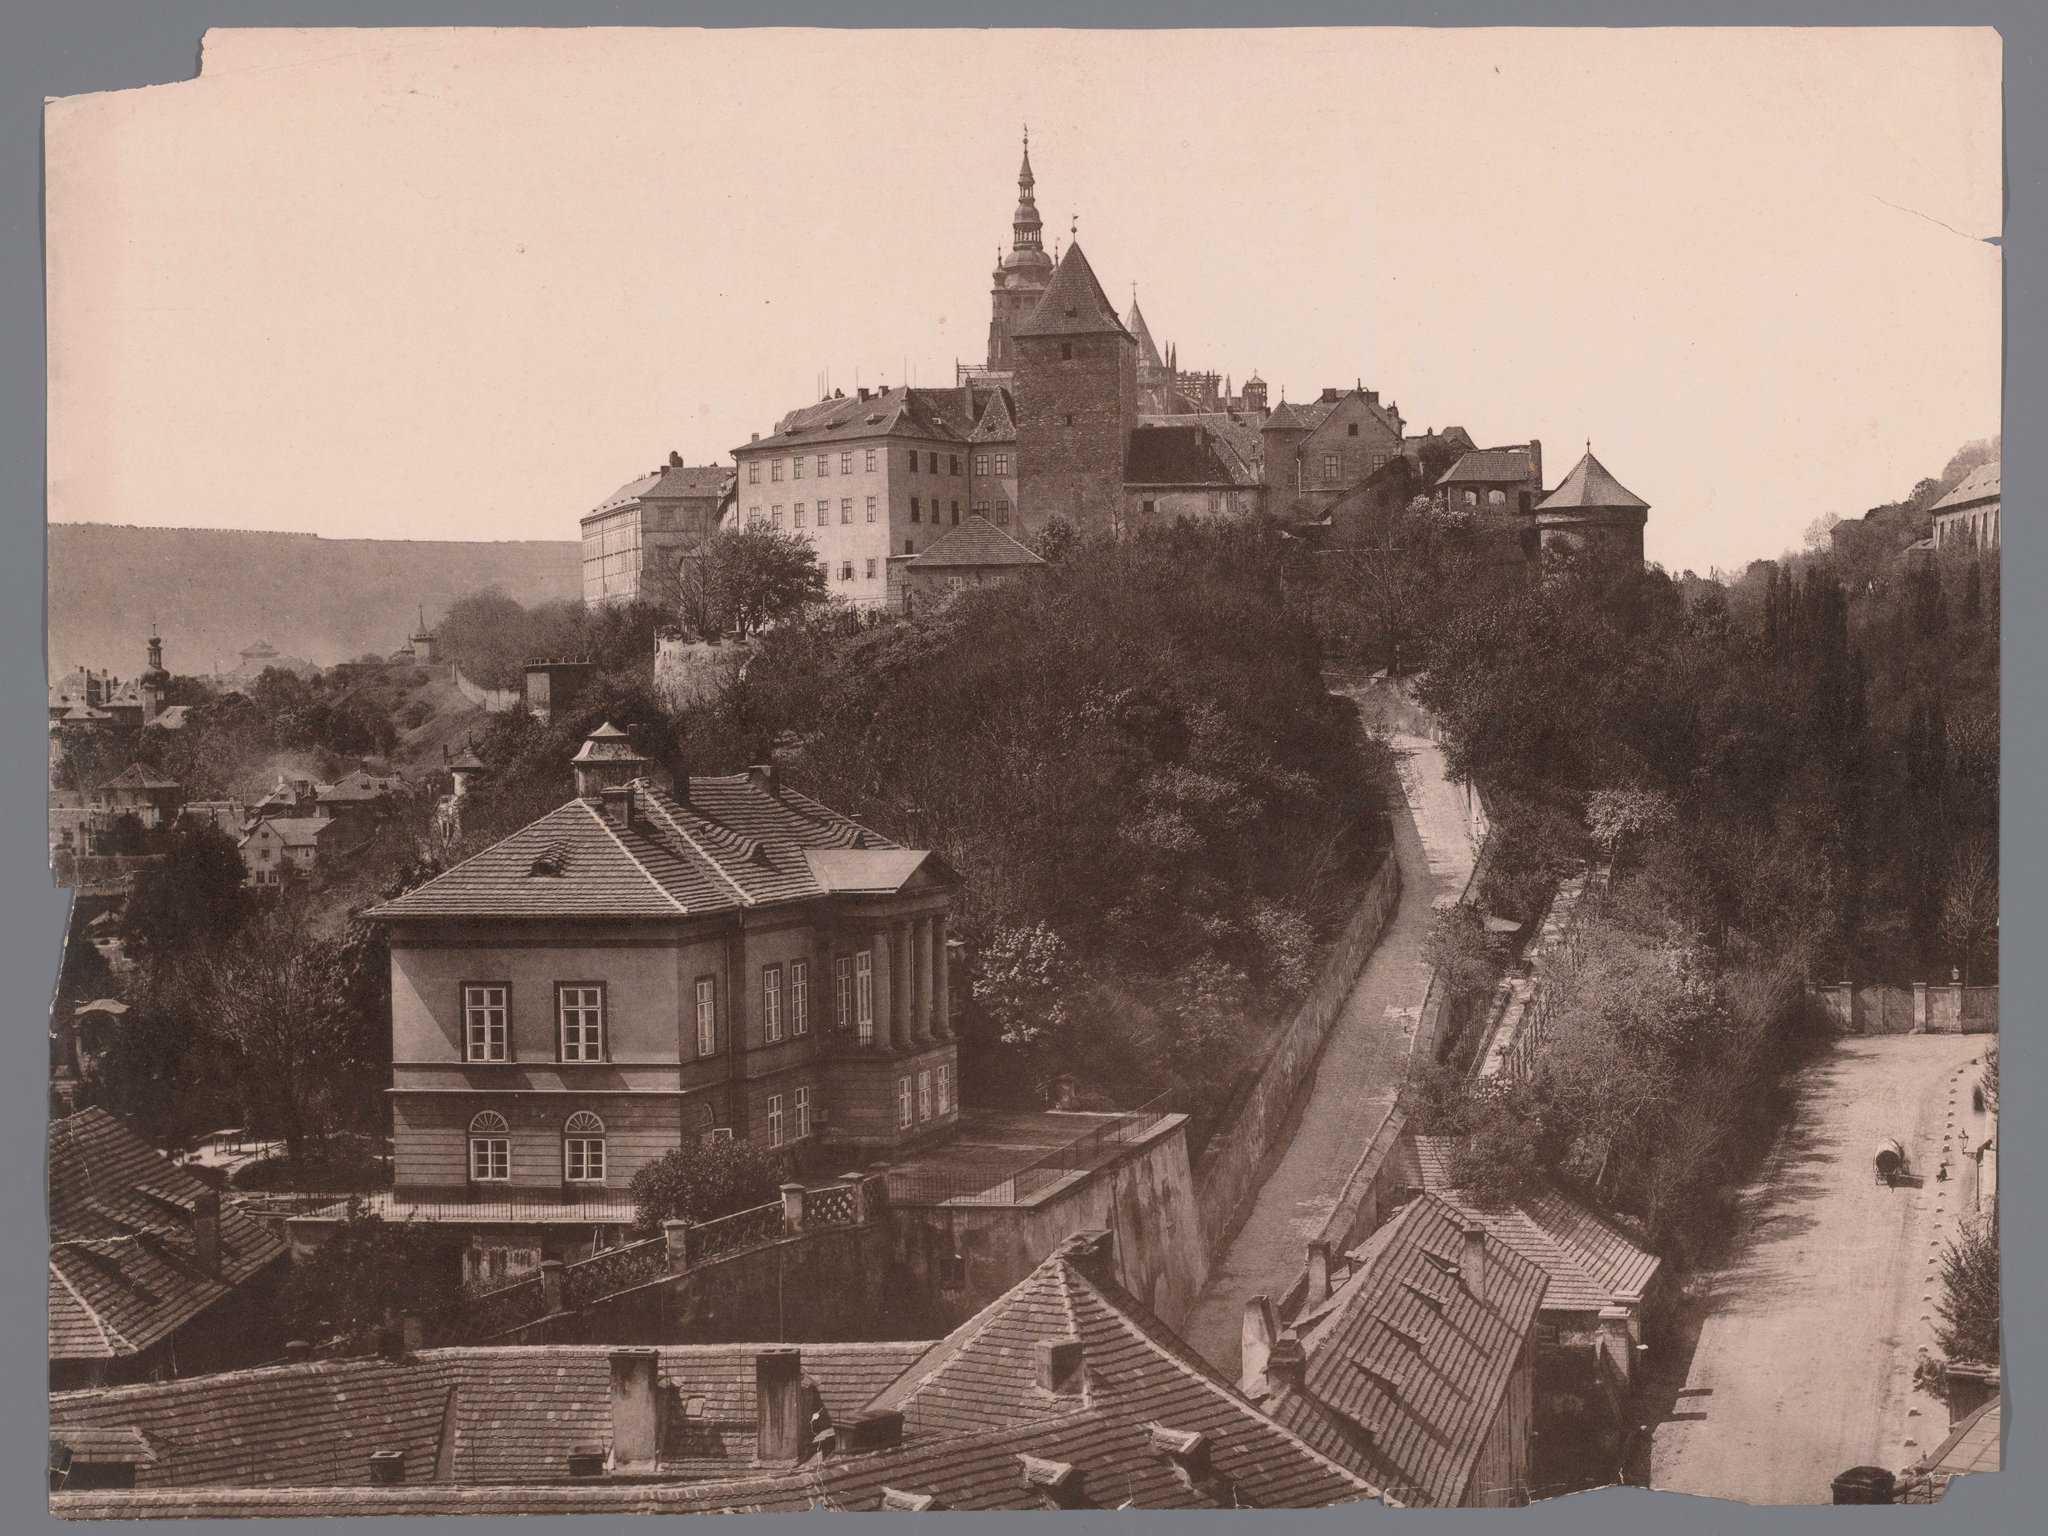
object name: photomechanical print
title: Gezicht op de Praagse burcht op het Hradčany in Praag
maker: Anonymous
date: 1870-1930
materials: paper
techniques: photograph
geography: prague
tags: fortress, palace